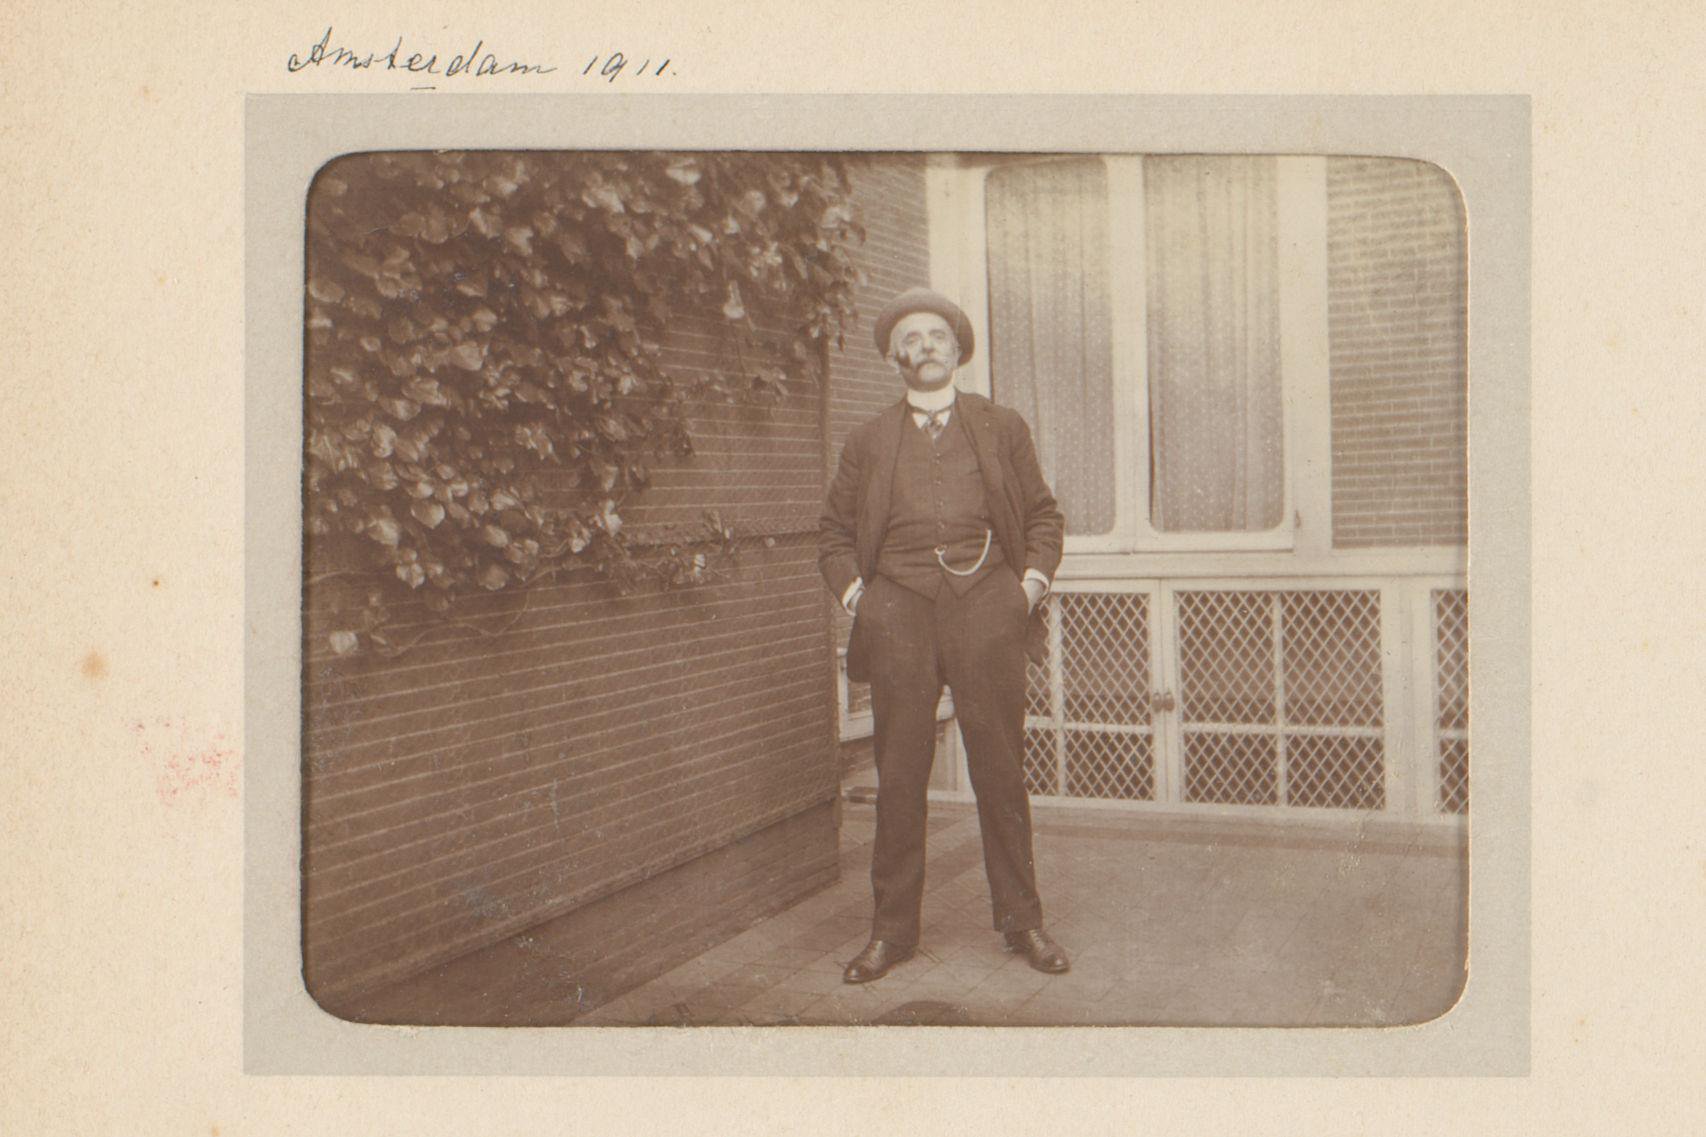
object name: photograph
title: Portret van een man met een pijp en zijn handen in zijn zakken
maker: liesbeth overhoff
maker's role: fotograaf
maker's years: 1895-1969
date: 1911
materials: paper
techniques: gelatin silver print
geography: amsterdam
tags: historical persons, pipe ~ tobacco, amsterdam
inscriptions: inscription: ‘Amsterdam 1911’